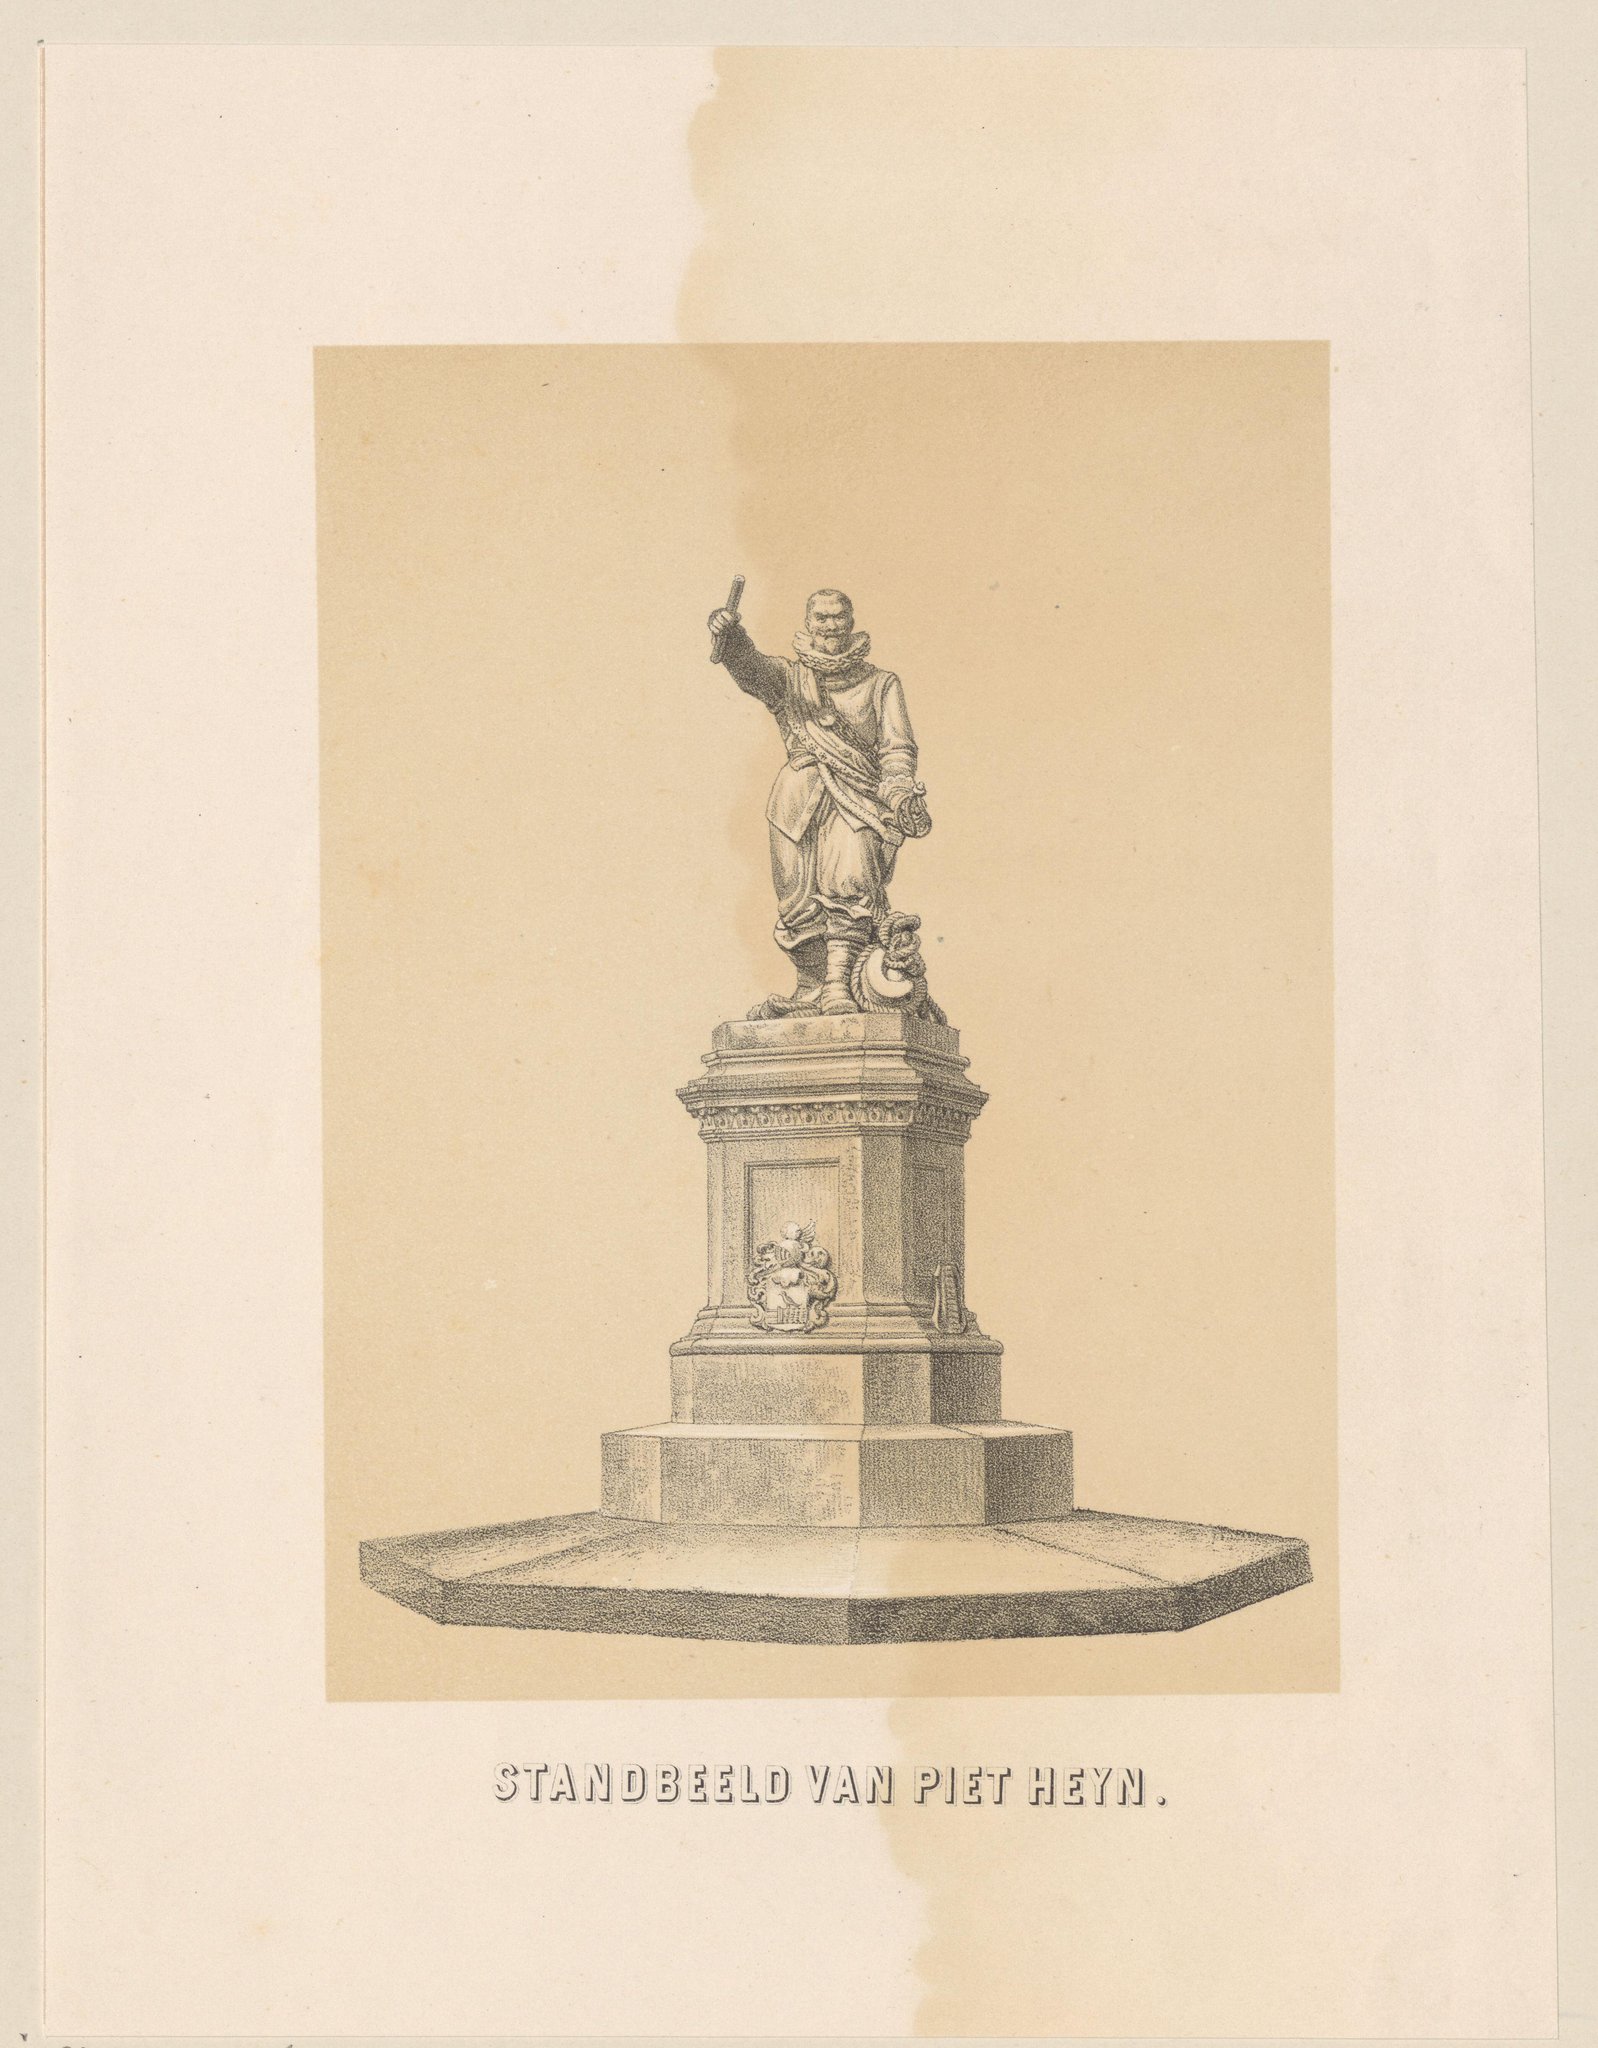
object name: print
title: Standbeeld van Piet Hein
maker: Anonymous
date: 1825-1874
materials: paper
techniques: tone lithography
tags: delfshaven, historical persons, monument, statue, commander-in-chief, admiral